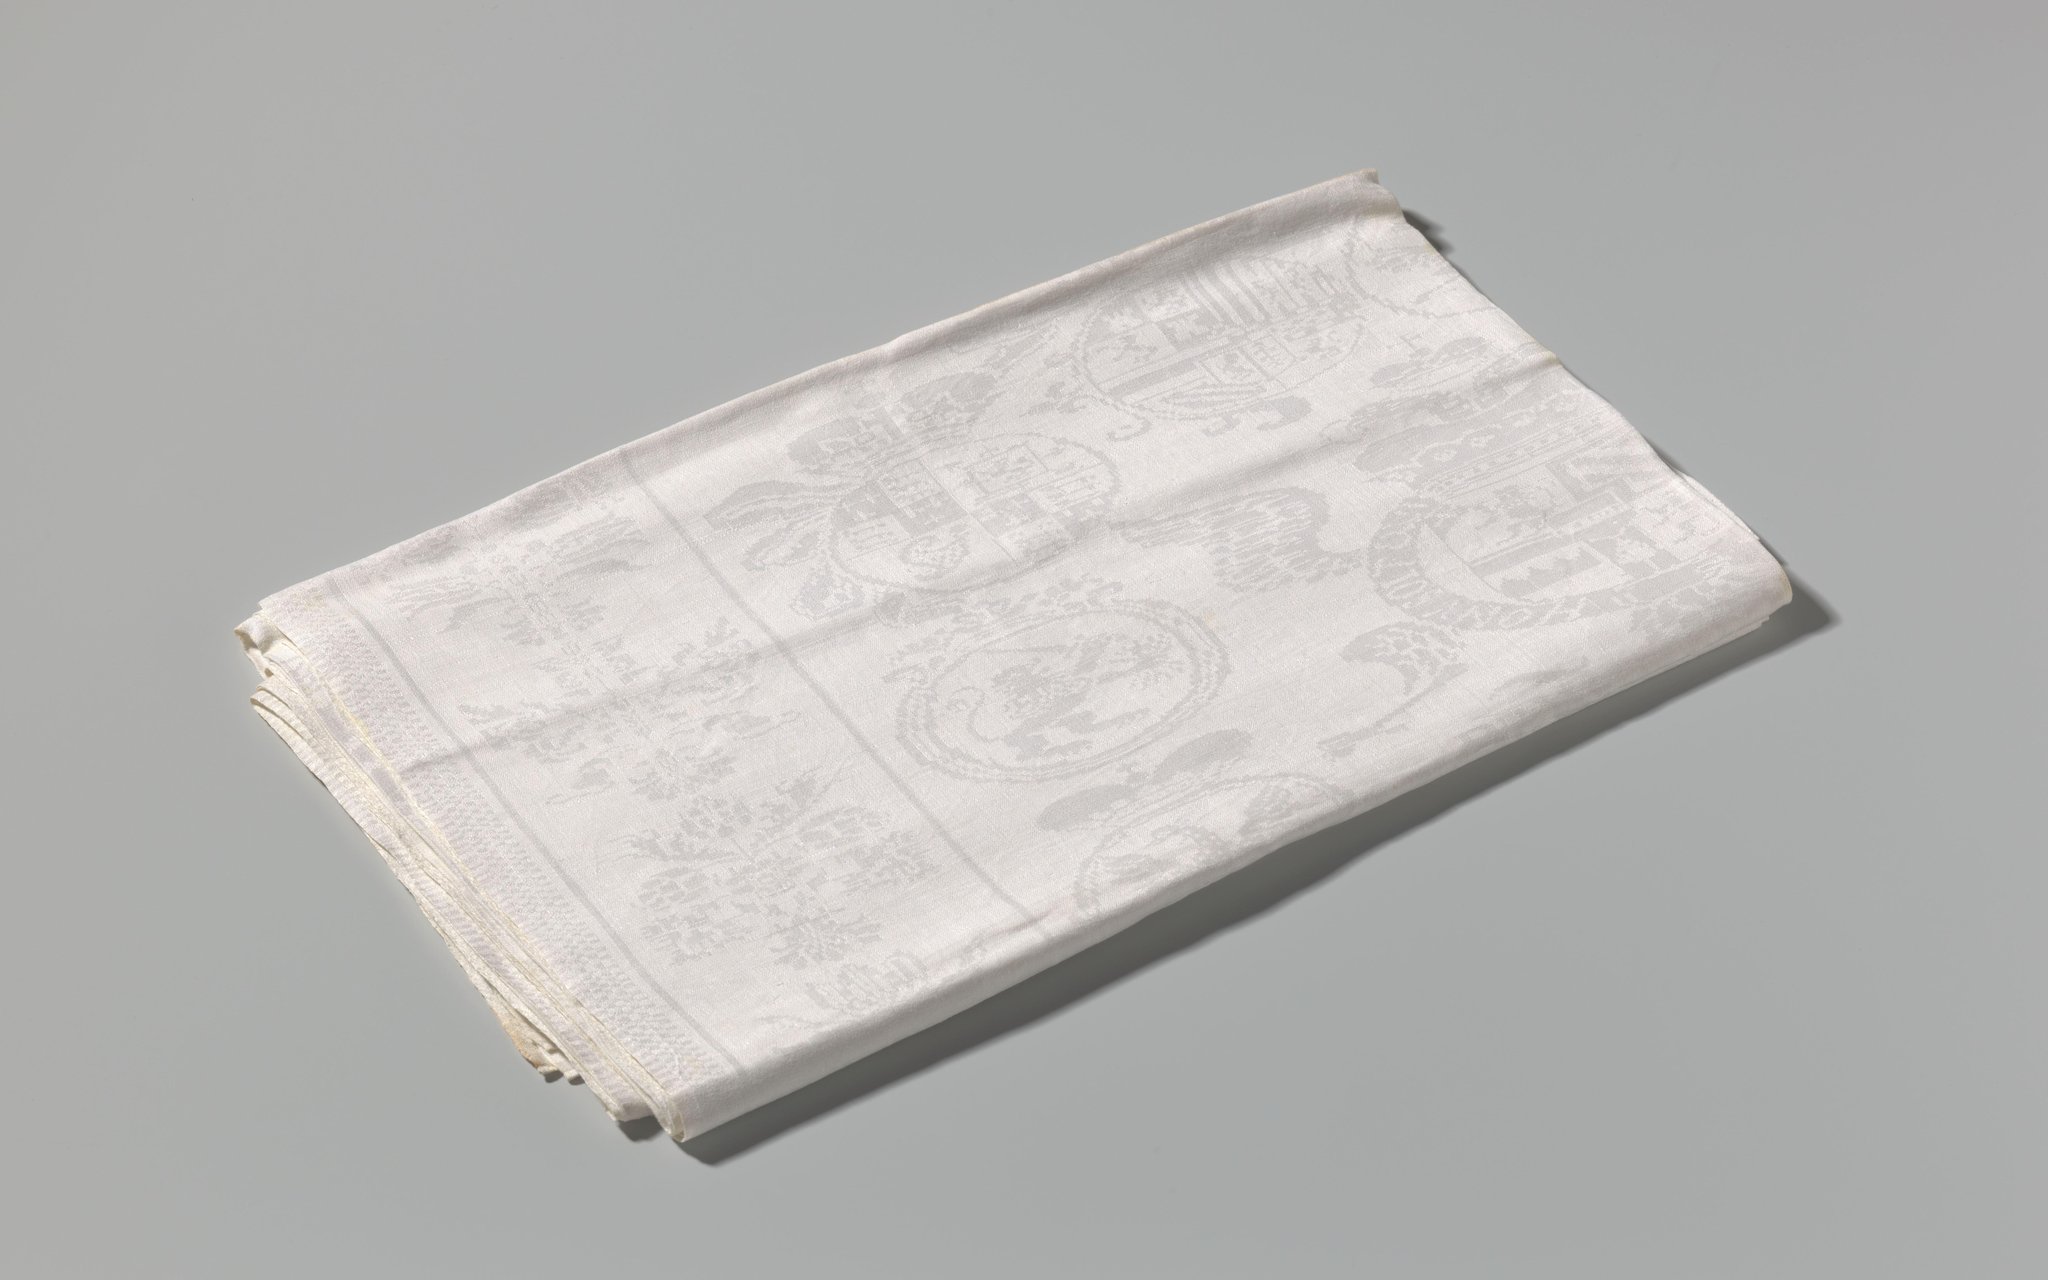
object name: tablecloth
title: Tafellaken met taferelen uit de Spaanse Successieoorlog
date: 1706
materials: linen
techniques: damask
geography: flanders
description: Wit linnen damasten tafellaken met taferelen uit de Spaanse Successieoorlog en de inweving "PRINC ET DVX DE MARLOBORVGH BELGIVM DEBELLAVIT" en "ANVERS", "MALINIS", "BRVSSEL", "LOVEN", "GENDT", "BRVGGE", "OSSTENDE" en "MEENEN".